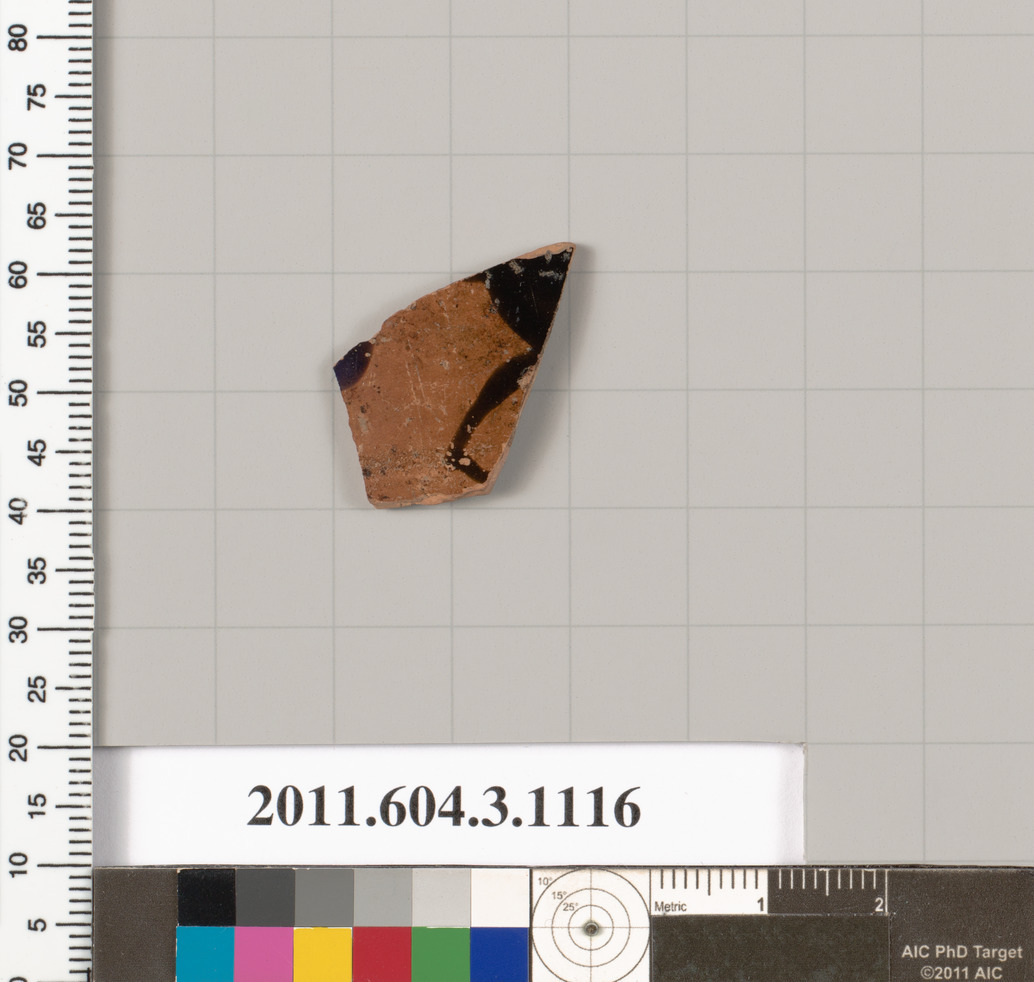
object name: mastoid or kyathos fragment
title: Terracotta fragment of a mastoid (drinking cup with narrow base) or a kyathos (cup-shaped ladle)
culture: greek, attic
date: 534-468 BCE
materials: terracotta